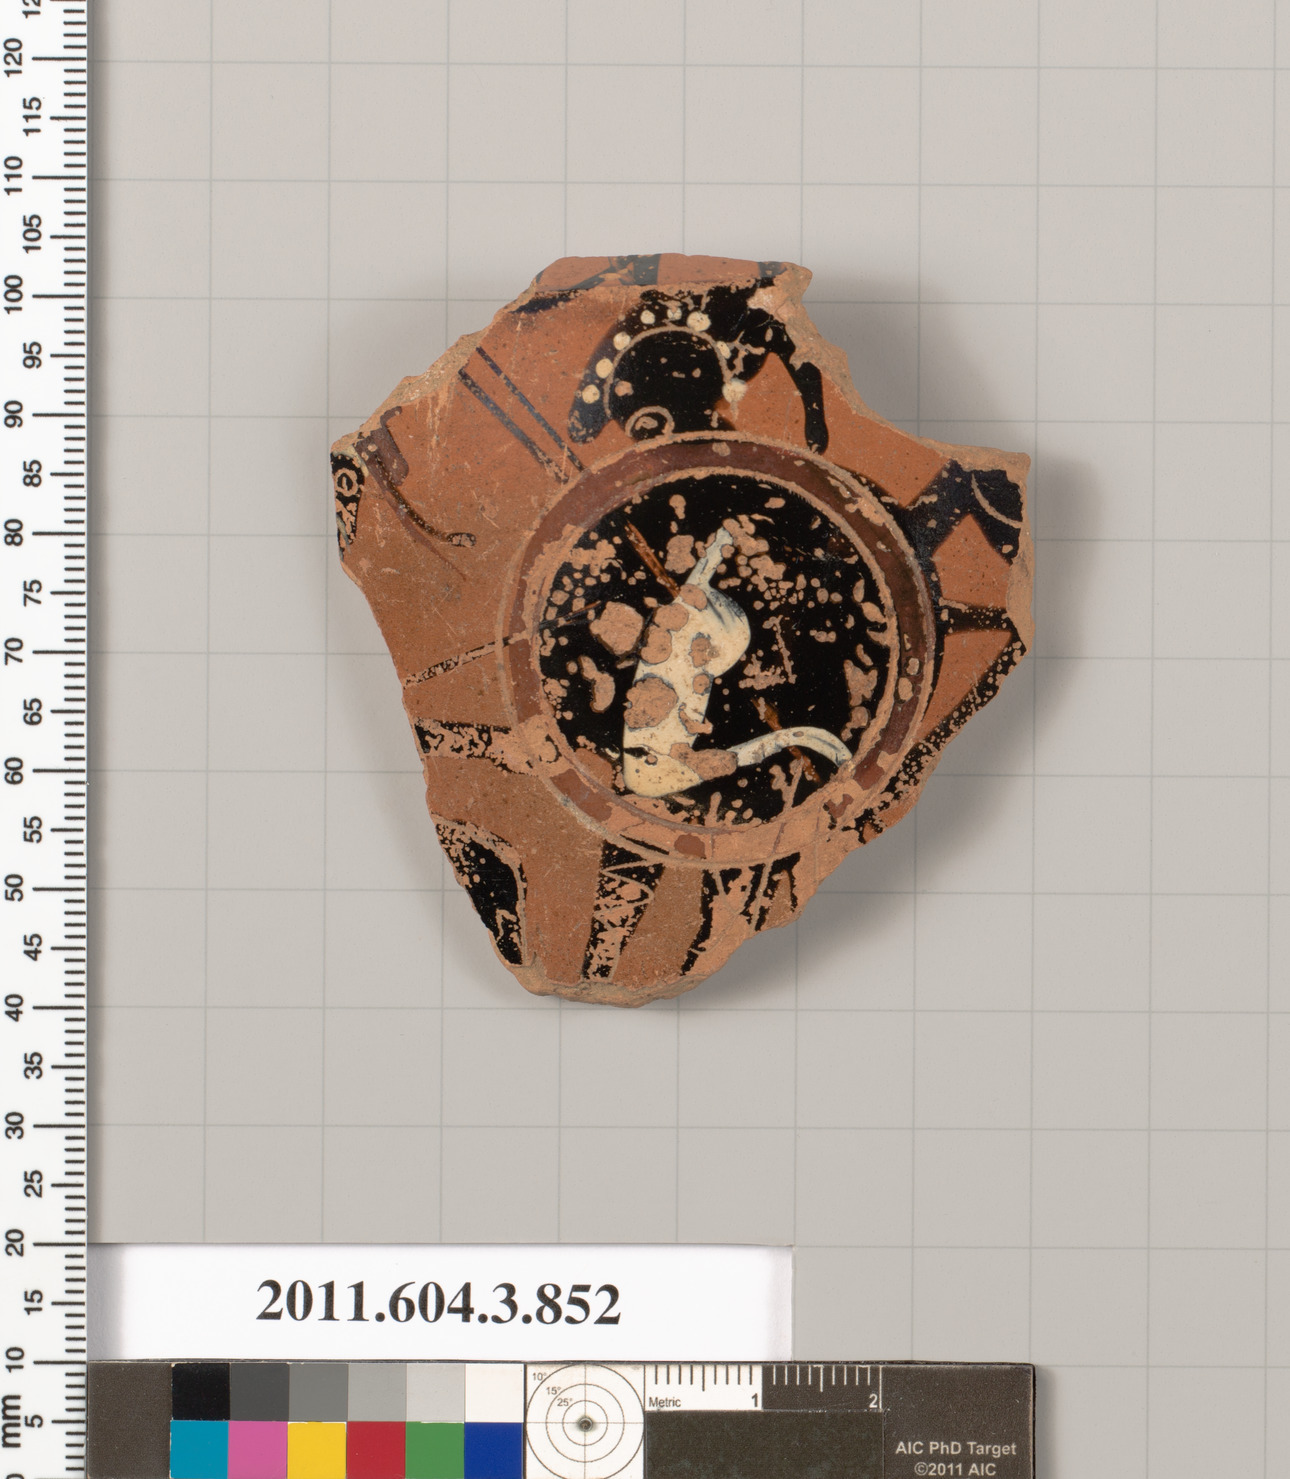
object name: lekythos fragment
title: Terracotta fragment of a lekythos (oil flask)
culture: greek, attic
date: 534-468 BCE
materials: terracotta